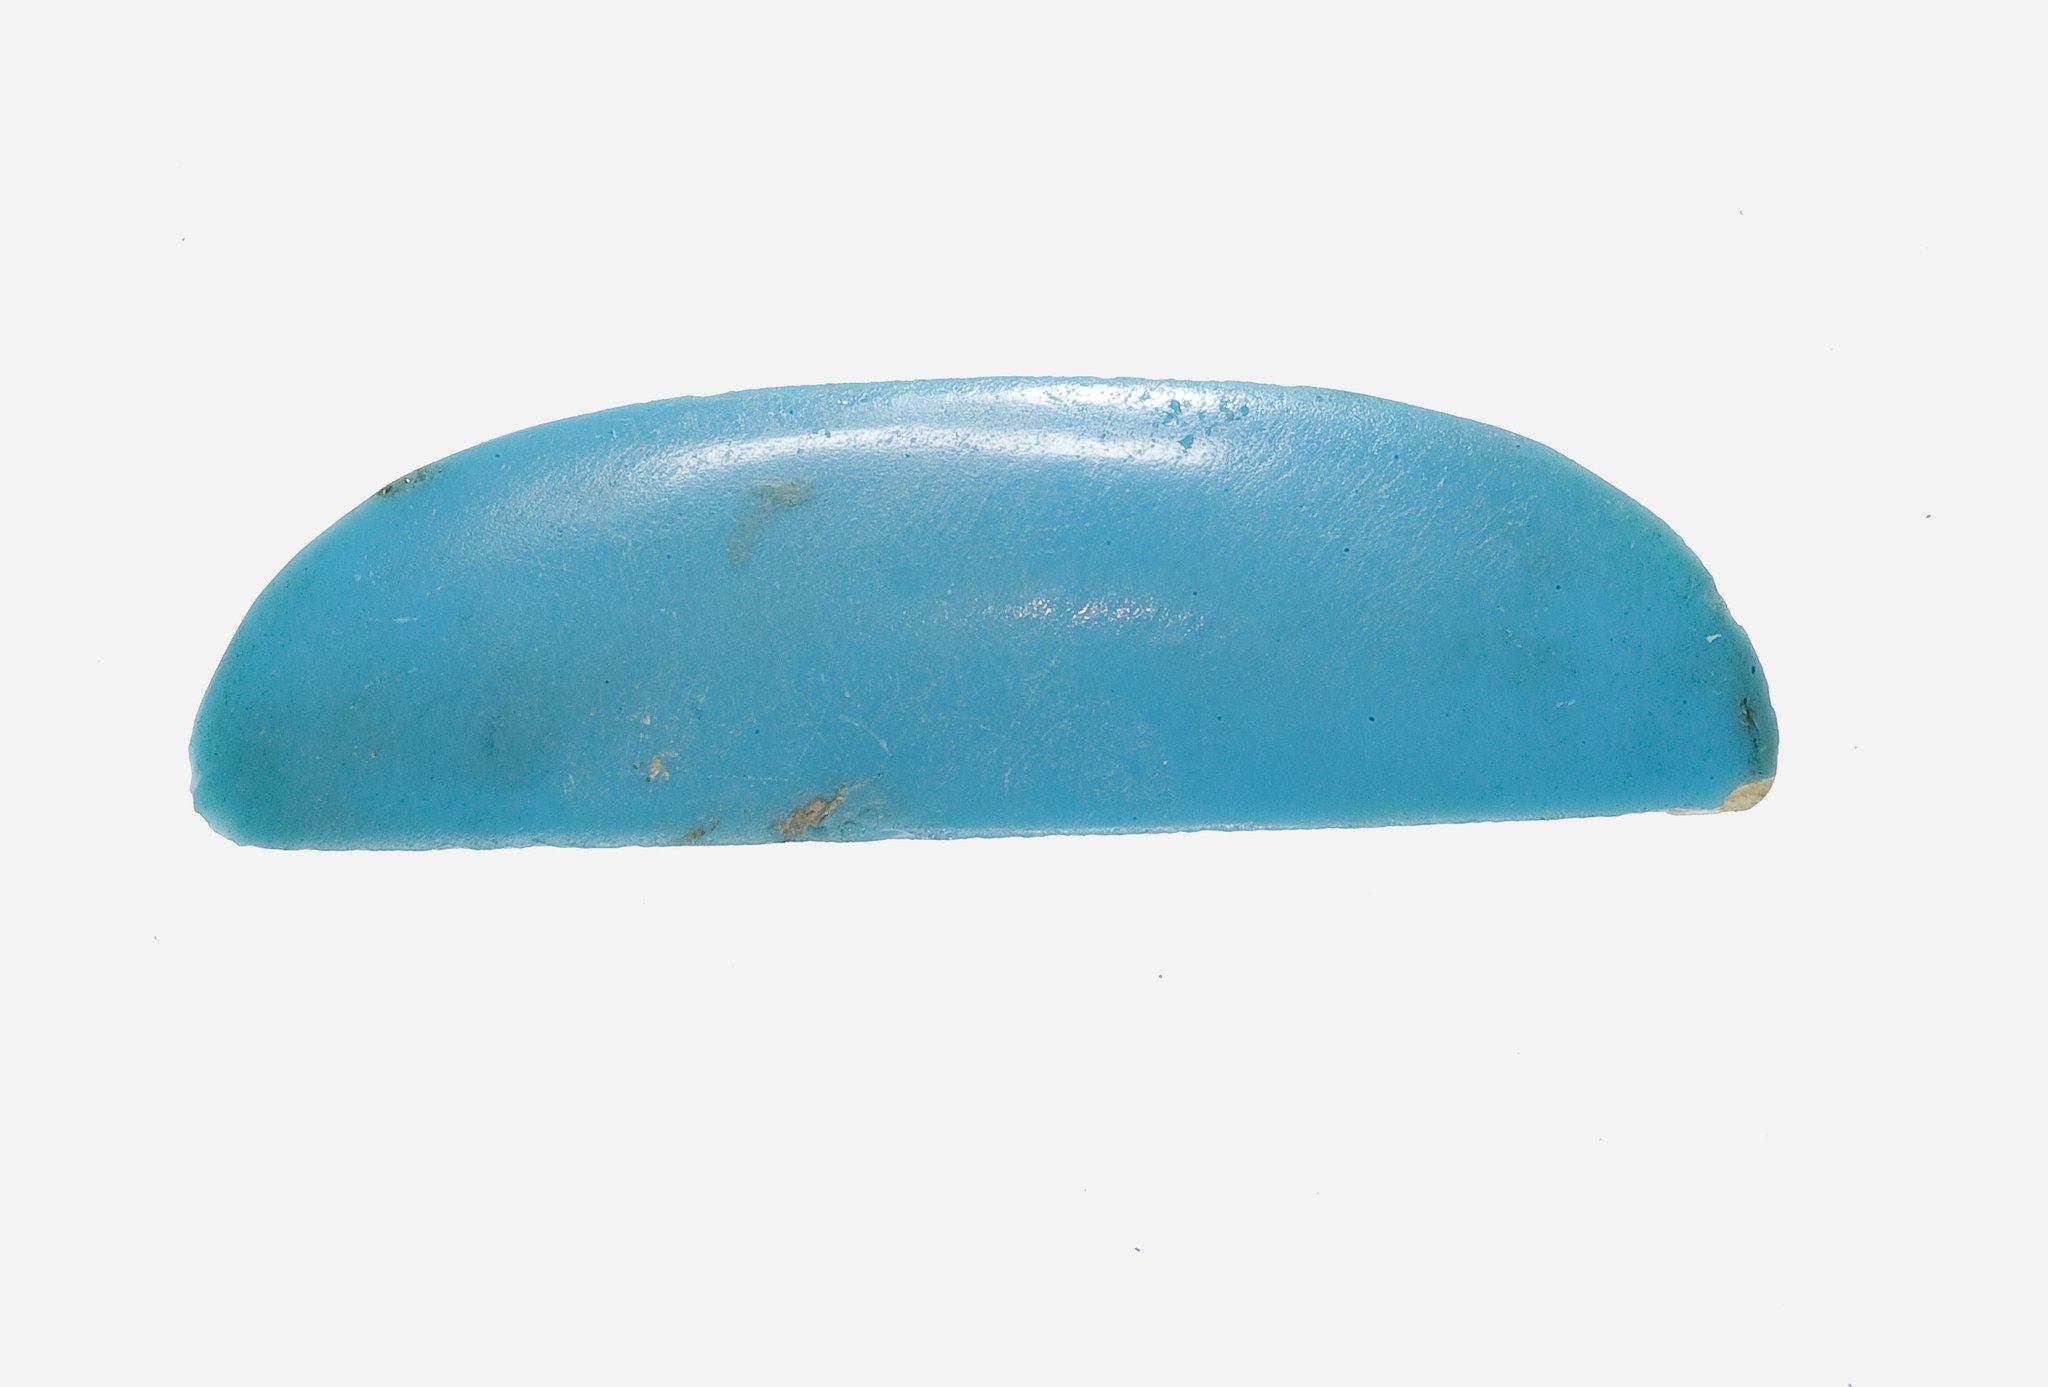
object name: inlay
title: Glass Inlay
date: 1390-1352 BCE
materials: glass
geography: egypt